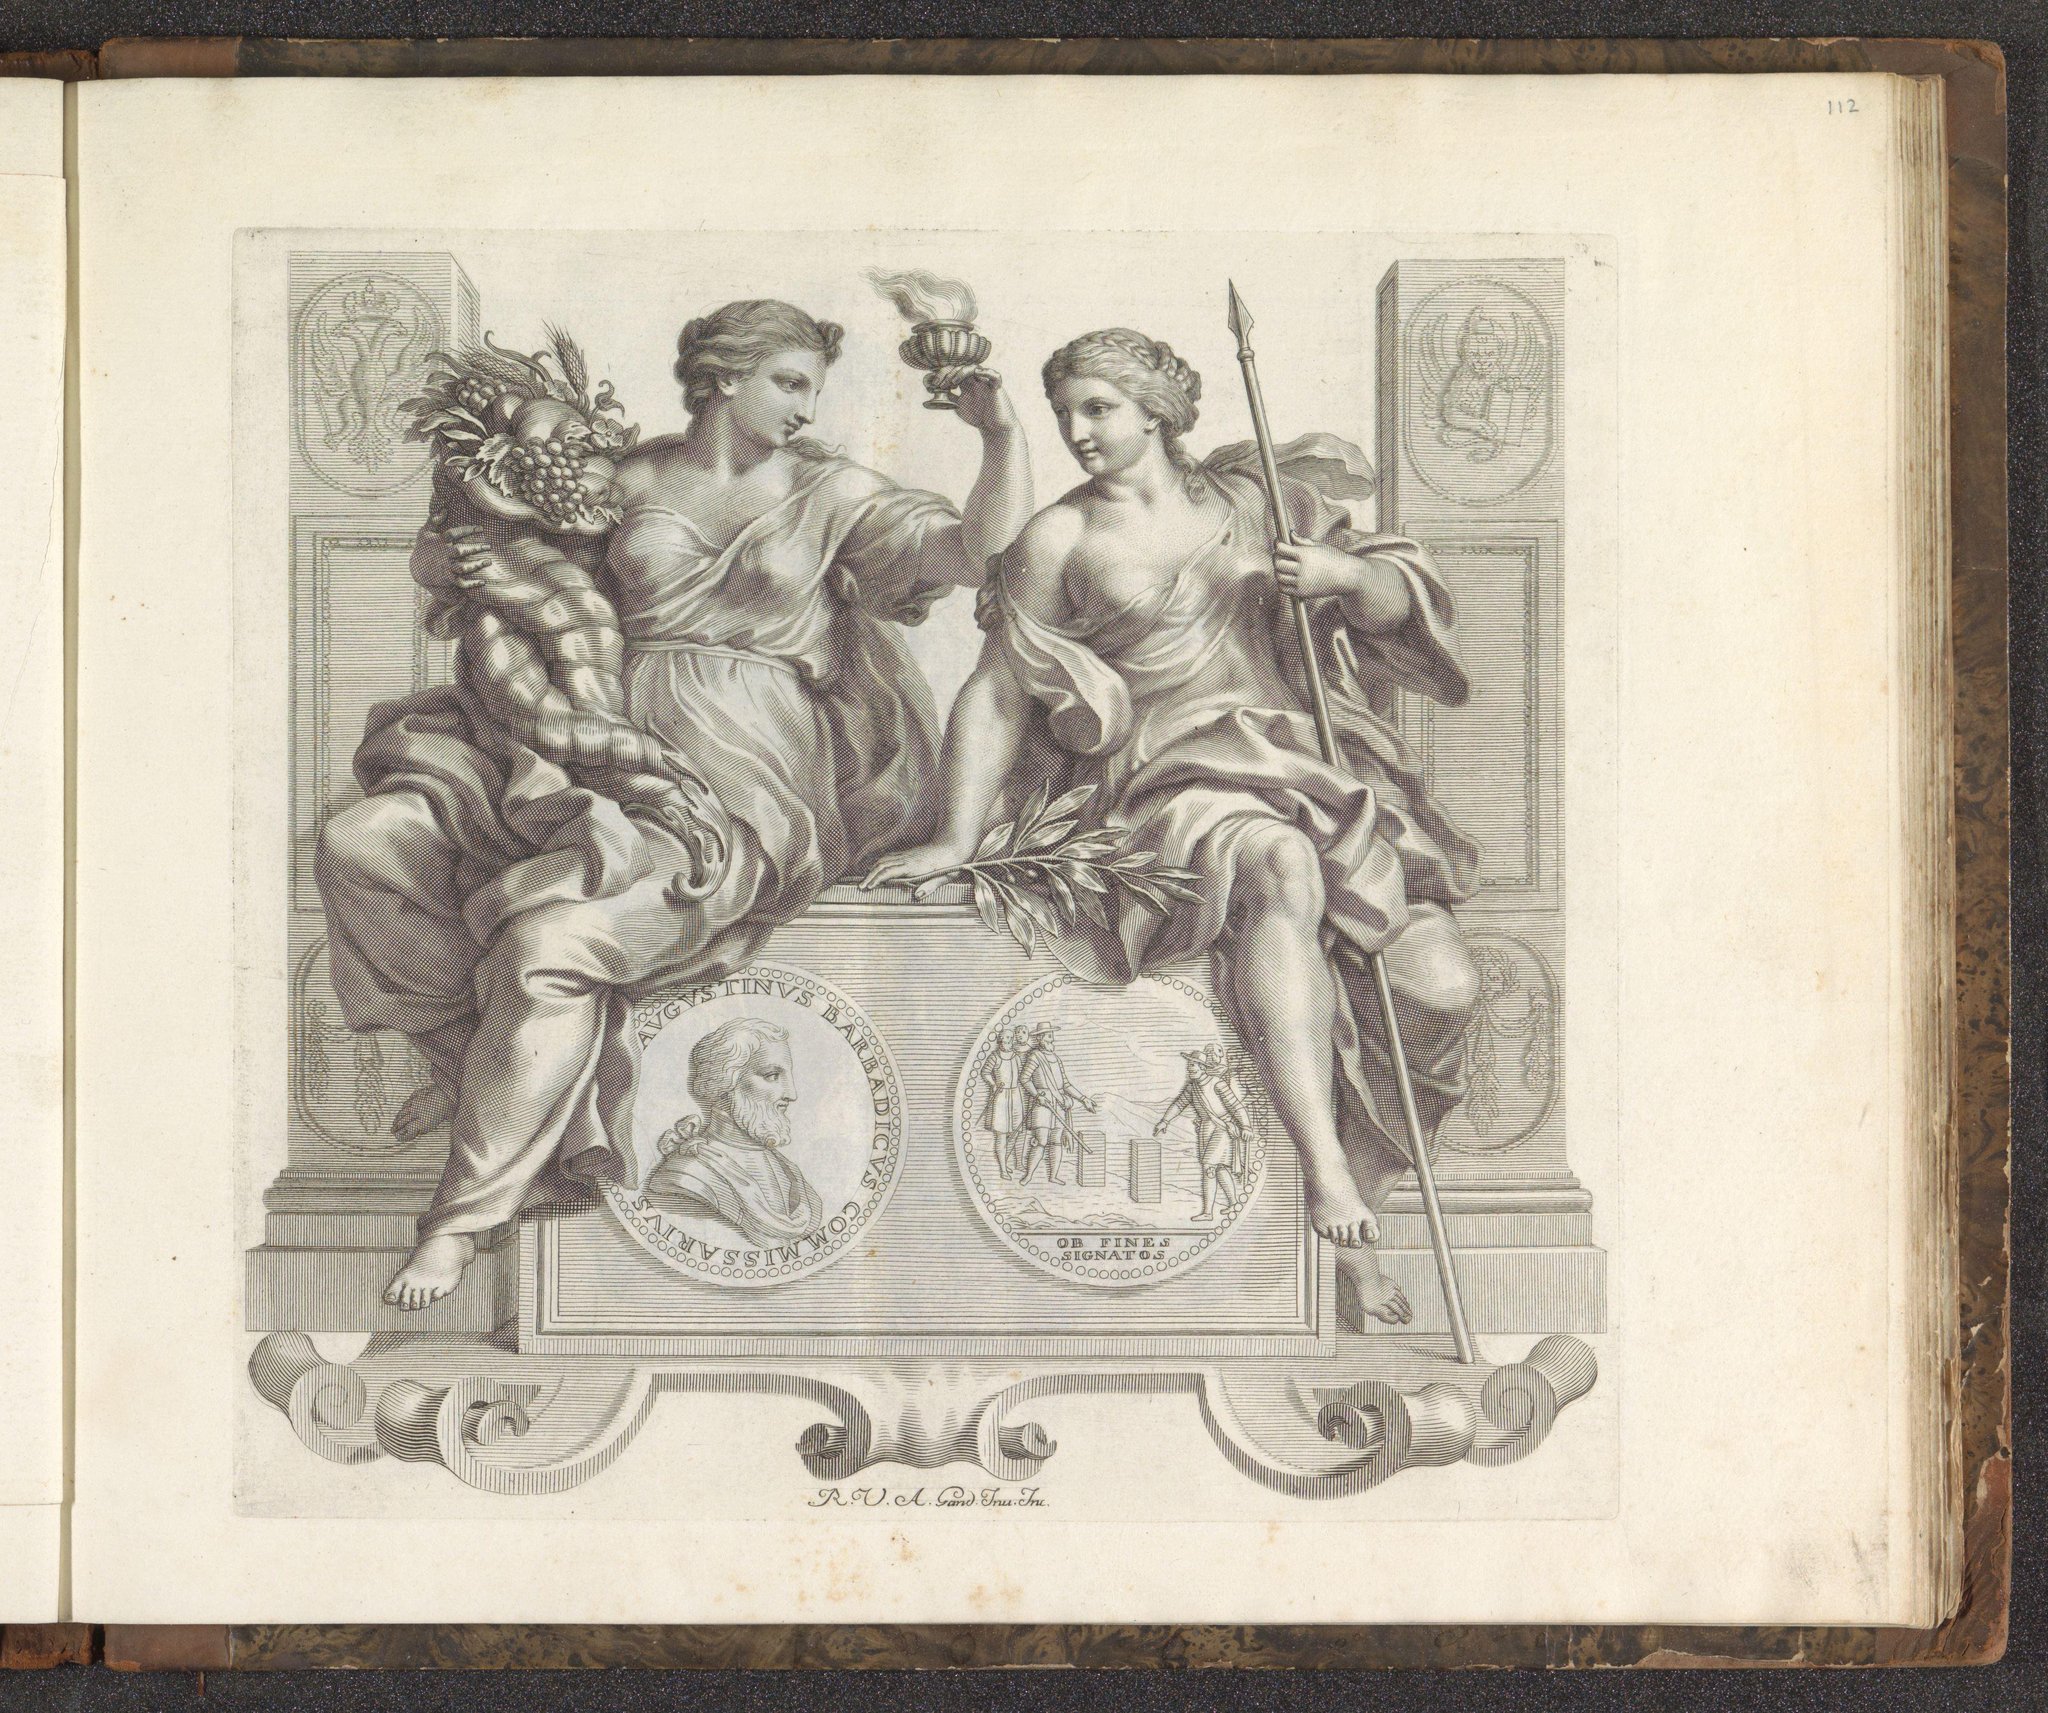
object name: print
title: Portret van Agostino Barbarigo en de personificaties van Eendracht en Vrede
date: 1673-1743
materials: paper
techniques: engraving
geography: rome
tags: agreement, unity; 'concordia', 'concordia insuperabile', 'concordia militare', 'concordia di pace', 'unione civile' (ripa), 'cornucopia', horn of plenty, symbols, allegories of peace, 'pax'; 'pace' (ripa), medal (considered as a piece of sculpture, regardless of its specific function), peace and prosperity, 'pax et abundantia'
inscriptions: collector's mark: Lugt 2228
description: Voetstuk in de vorm van een cartouche. Daarop een medaillon met op de voorzijde het portret van Agostino Barbarigo in harnas. Op de achterzijde plaatsten twee commissies een grenssteen. Gezien de wapenschilden in de linker- en rechter bovenhoek betreft het de grensstenen van keizer Ferdinand I en Venetië. Links op het voetstuk zit de personificatie Eendracht met in haar rechterhand twee cornucopia die met elkaar verstrengeld zijn en in haar linkerhand een vuurbeker. De vrouw rechts heeft een spies en olijftak in haar handen. Ze is de personificatie van de Vrede. De prent maakt deel uit van een album.